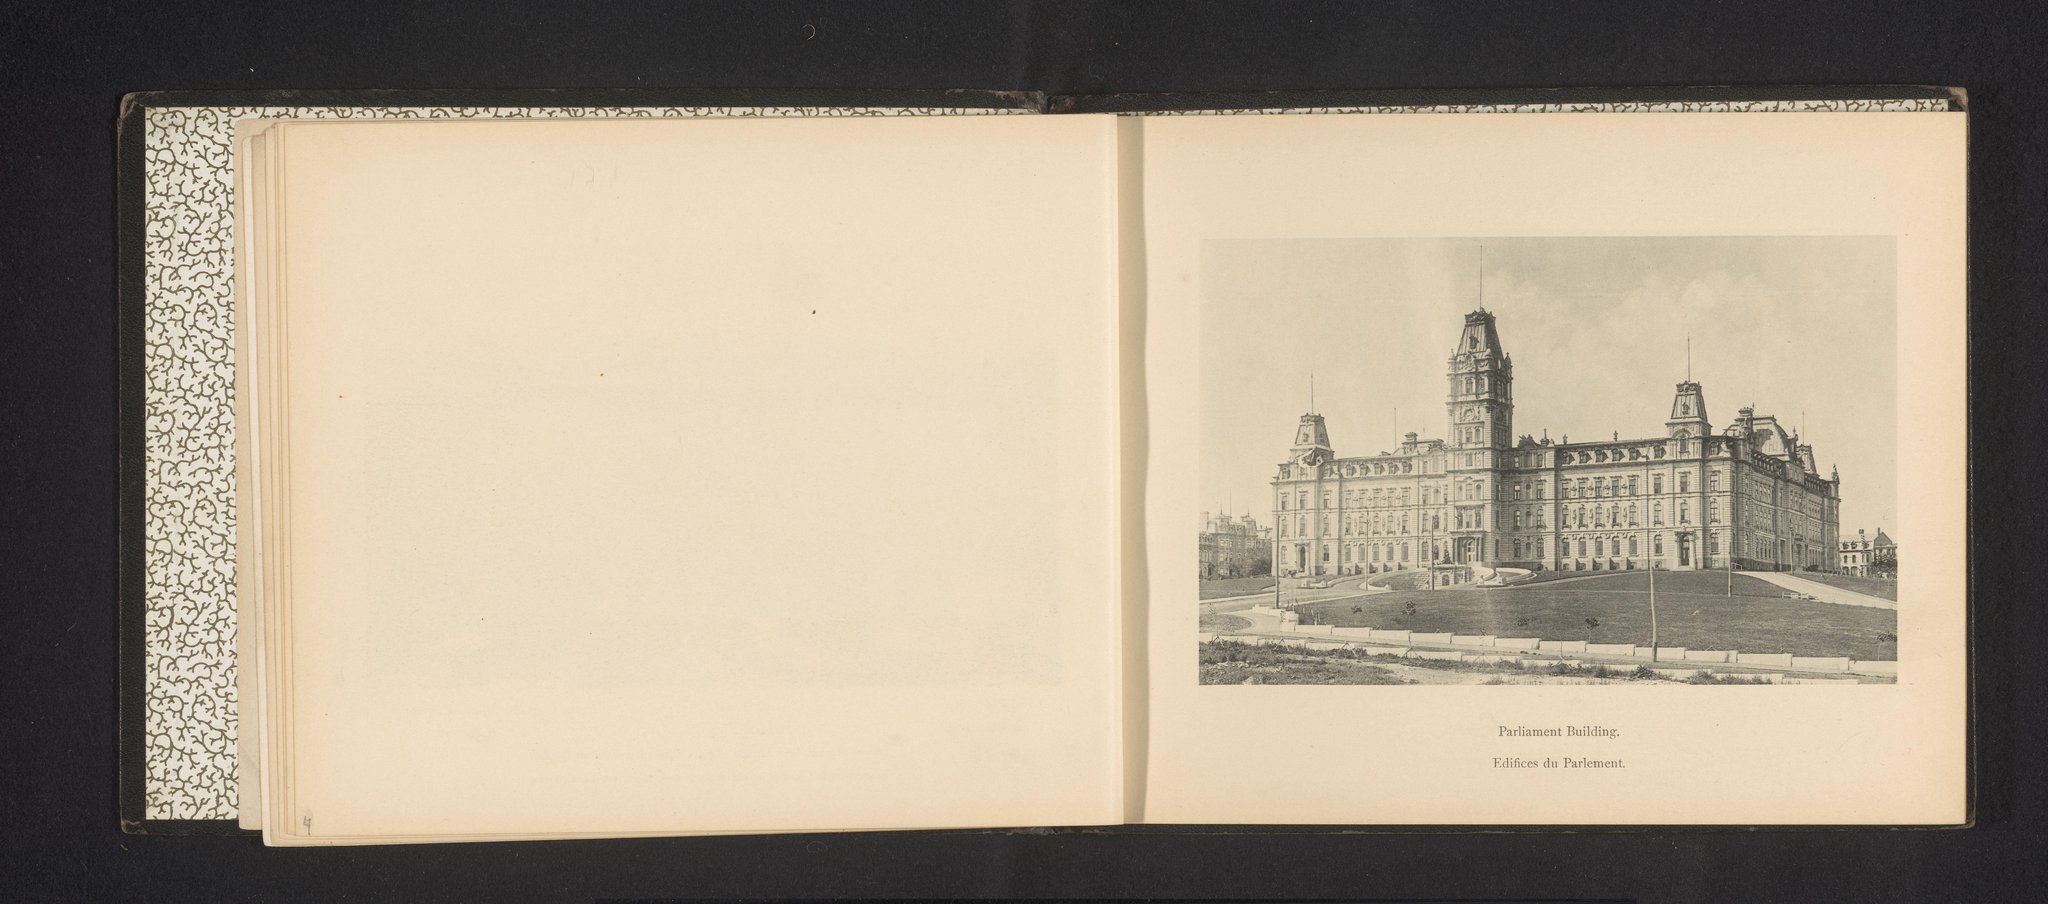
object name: page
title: Gezicht op het parlementsgebouw van Québec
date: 1889-1894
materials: paper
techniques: photograph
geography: quebec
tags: façade (of house or building), québec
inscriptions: inscription: ‘Edifices du Parlement’